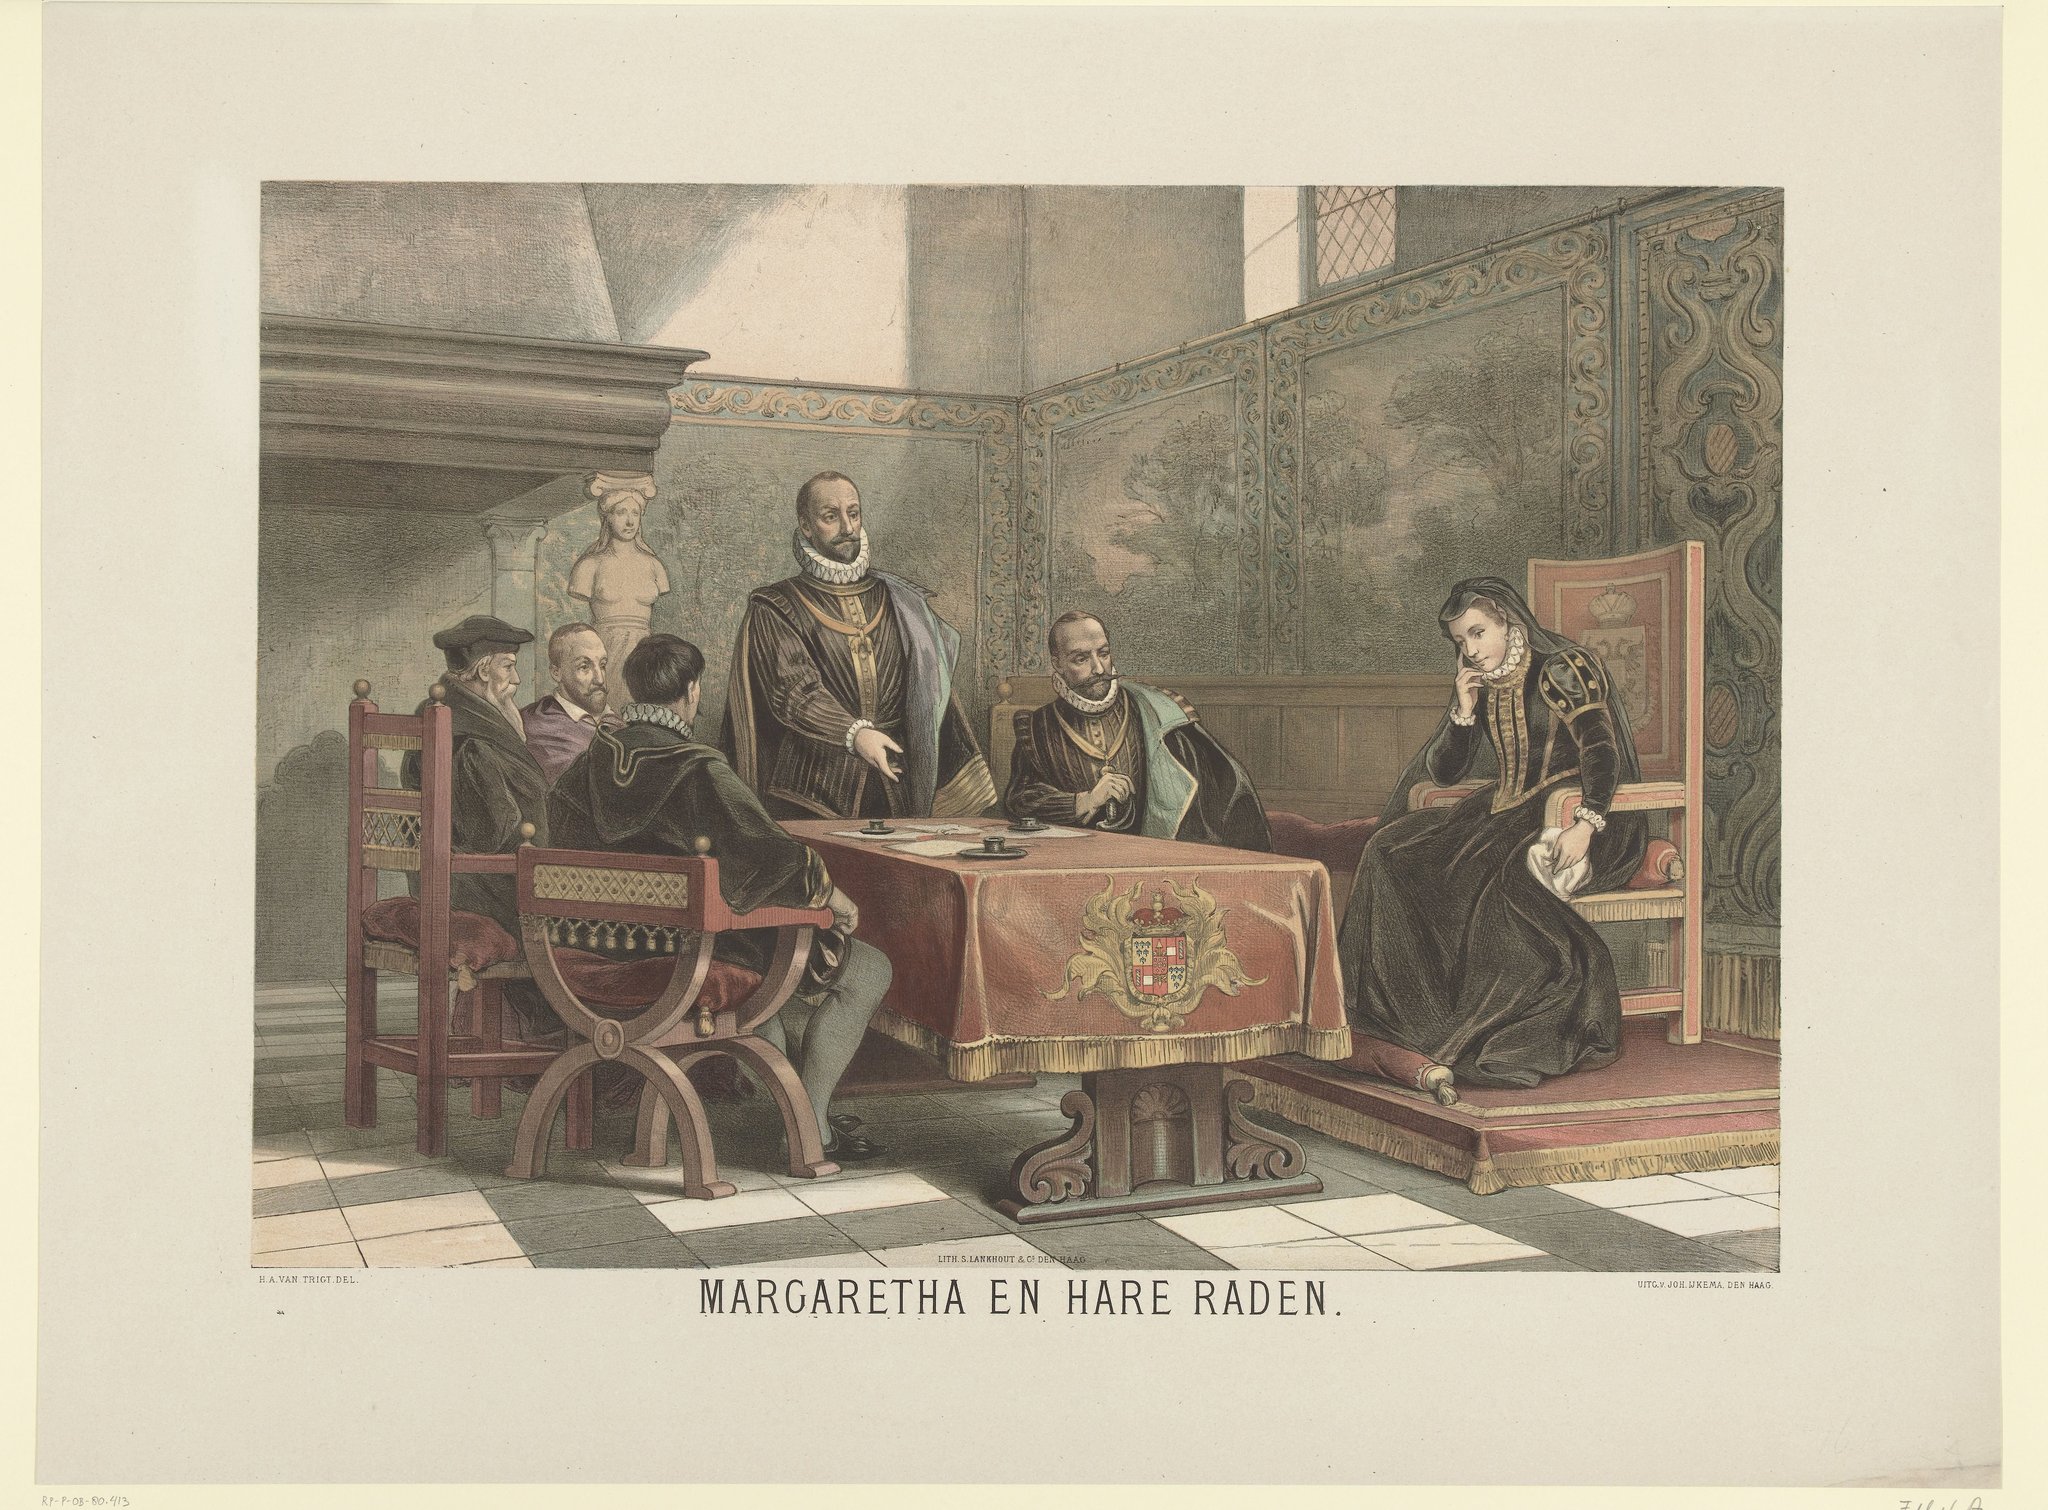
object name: history print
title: Serie van 24 vaderlandsche historieplaten, voor School en Huis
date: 1878-1880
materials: paper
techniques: lithograph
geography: netherlands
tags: national government, brussels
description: Interieur met Margaretha van Parma, landvoogdes der Nederlanden, zittend op haar troon in overleg met haar raadgevers, ca. 1560. Rond een tafel vijf raadgevers, een staande vliesridder spreekt haar toe.